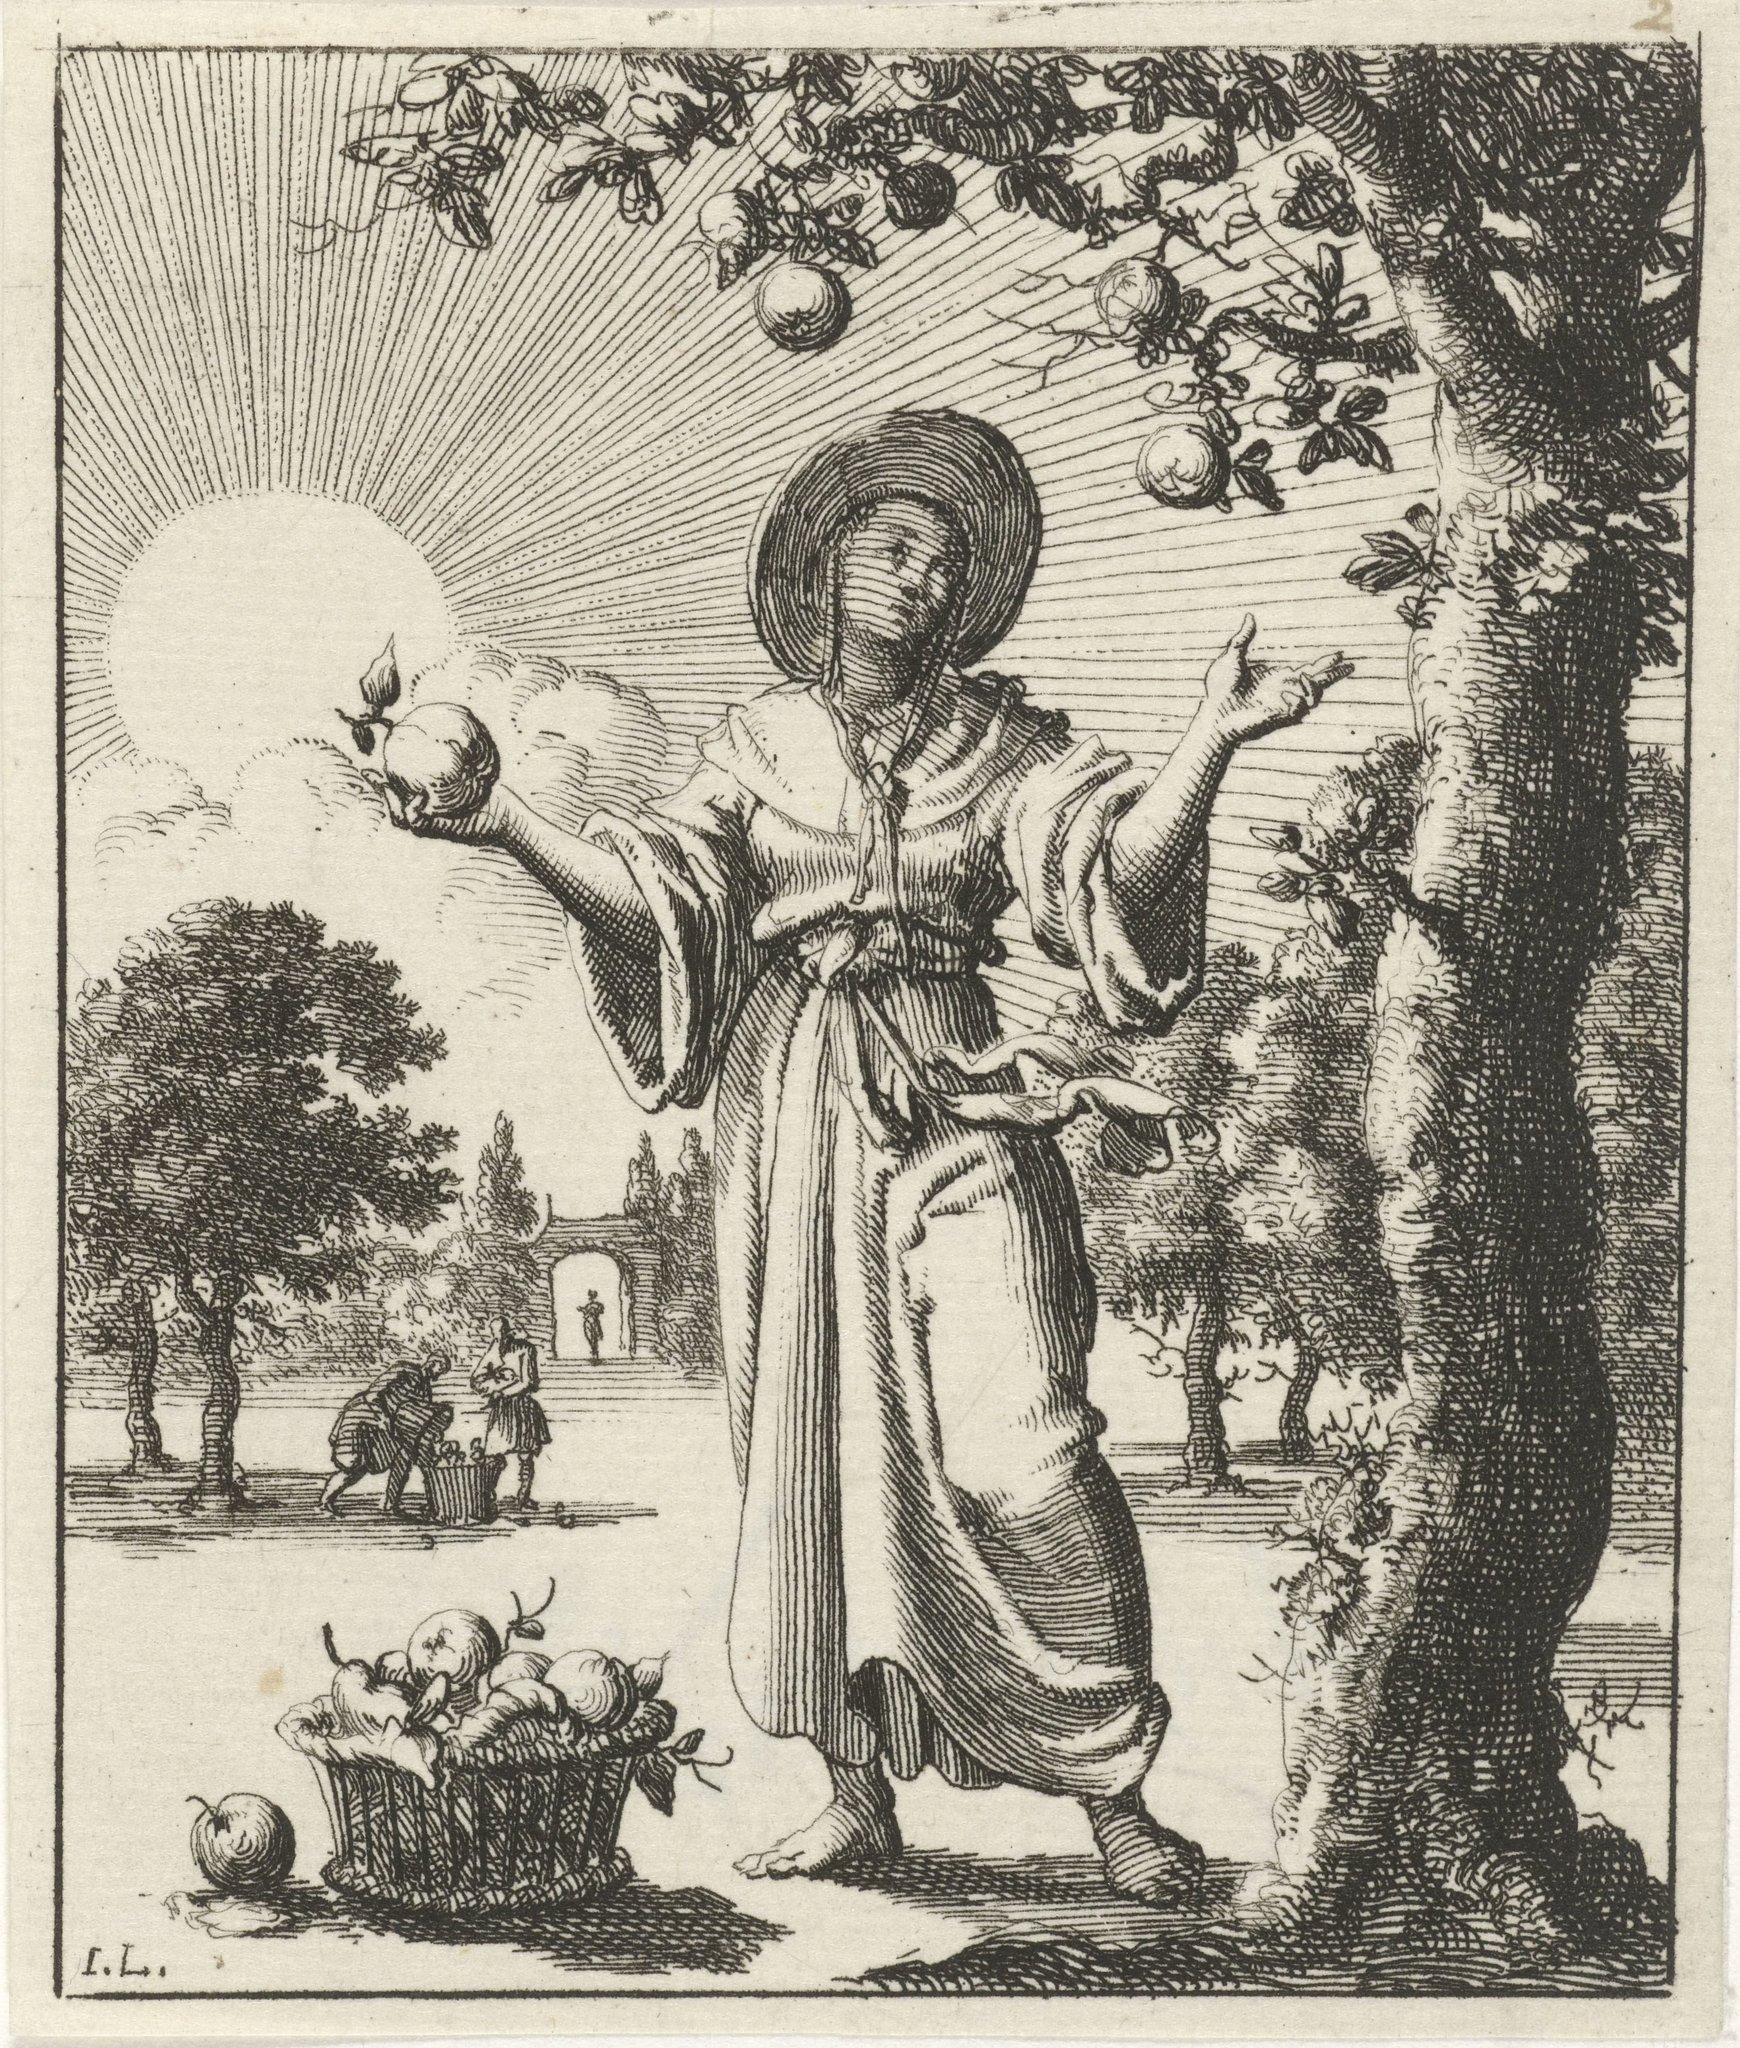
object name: print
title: Niet ontydig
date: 1687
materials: paper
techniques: etching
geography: amsterdam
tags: picking fruit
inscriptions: collector's mark: Lugt 2228, number: ‘2’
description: Illustratie uit: Luyken, Jan. Voncken der liefde Jesu, van het godtbegerende zielenvier. Amsterdam: Pieter Arentsz (II), 1687, p. 6.